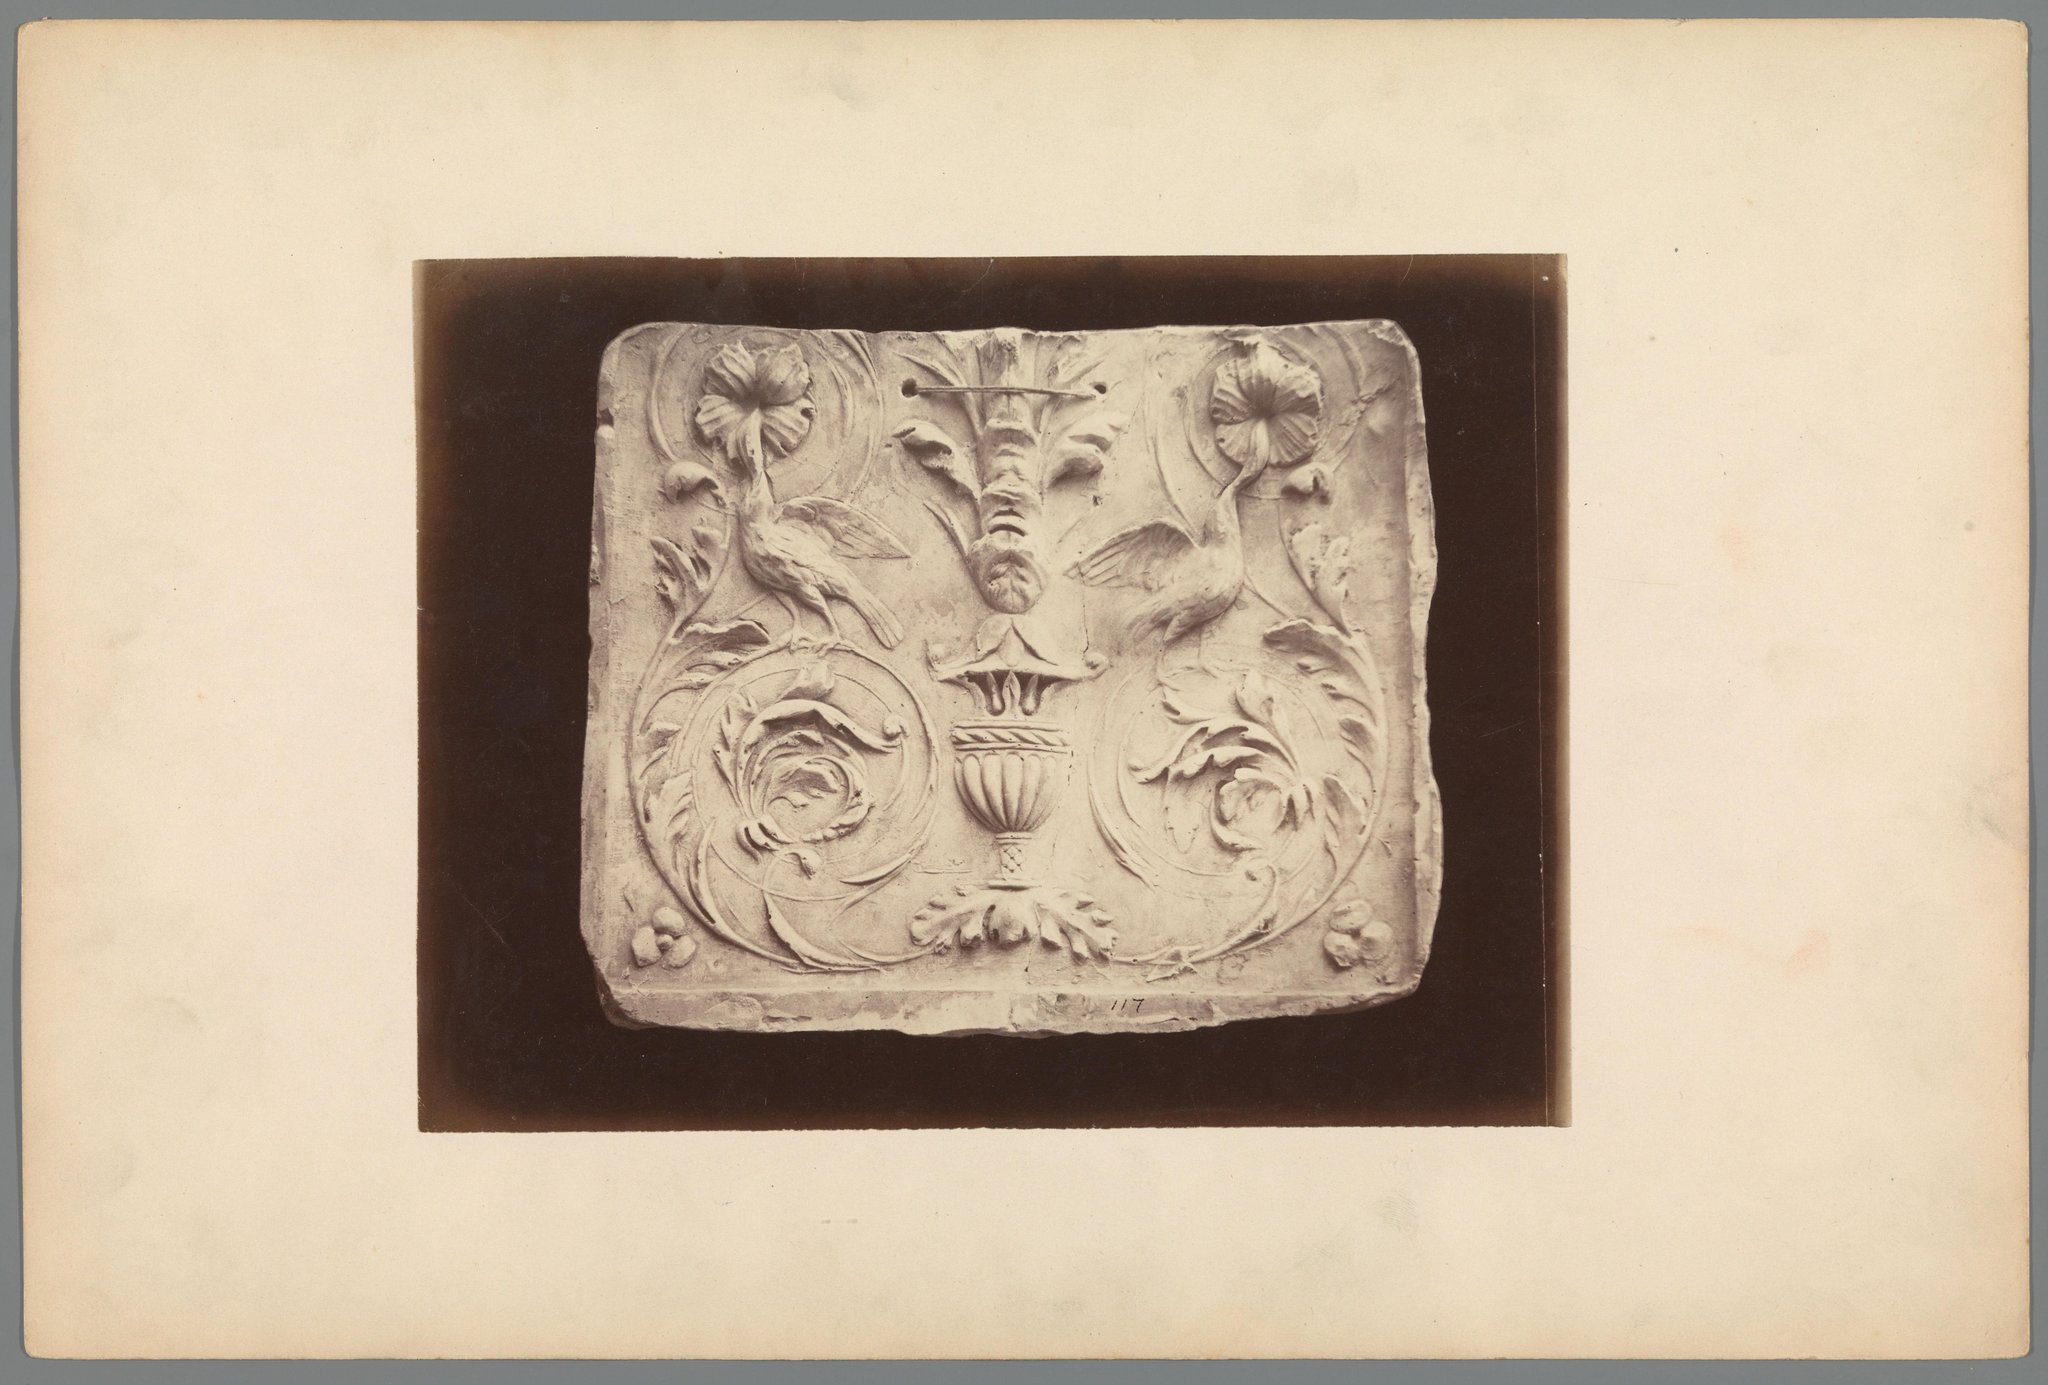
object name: photograph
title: Reliëf met bladmotieven, bloemen en vogels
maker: Anonymous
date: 1875-1900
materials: cardboard, photographic support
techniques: albumen print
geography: europe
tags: ornamental birds, flowers ~ ornament, sculpture (+ relief ~ sculpture), europe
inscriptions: collector's mark: Lugt 3937, number: ‘117’